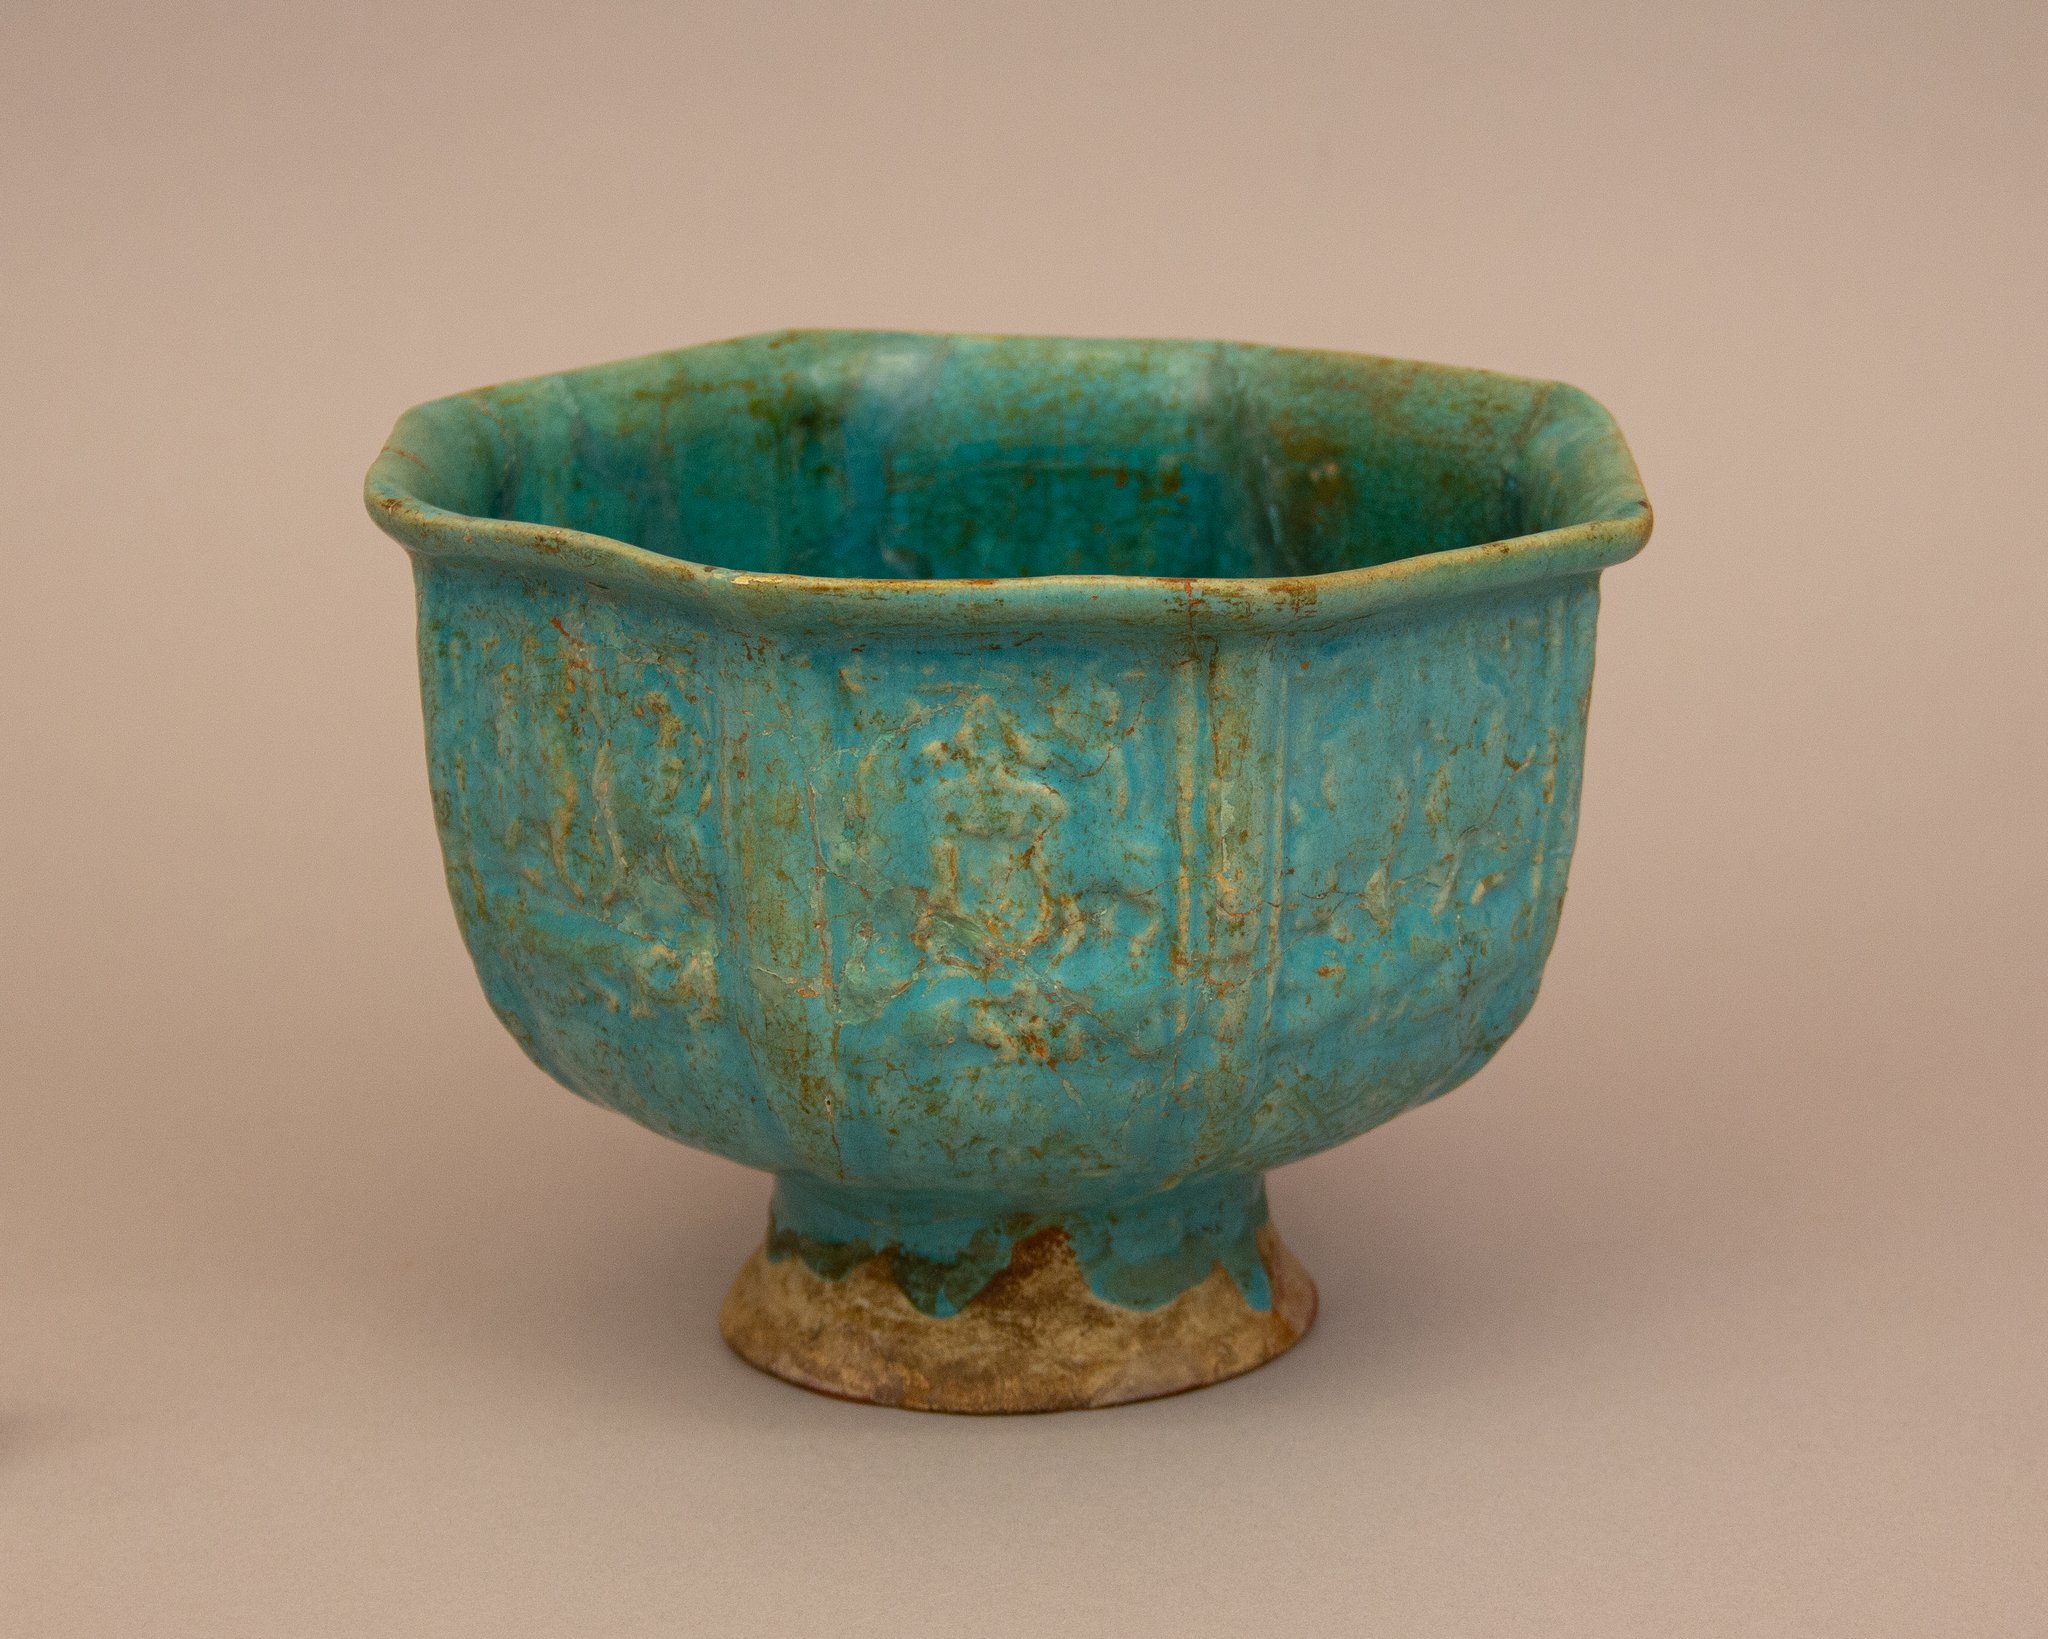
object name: bowl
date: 1101-1200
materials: glaze, stonepaste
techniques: painting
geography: iran